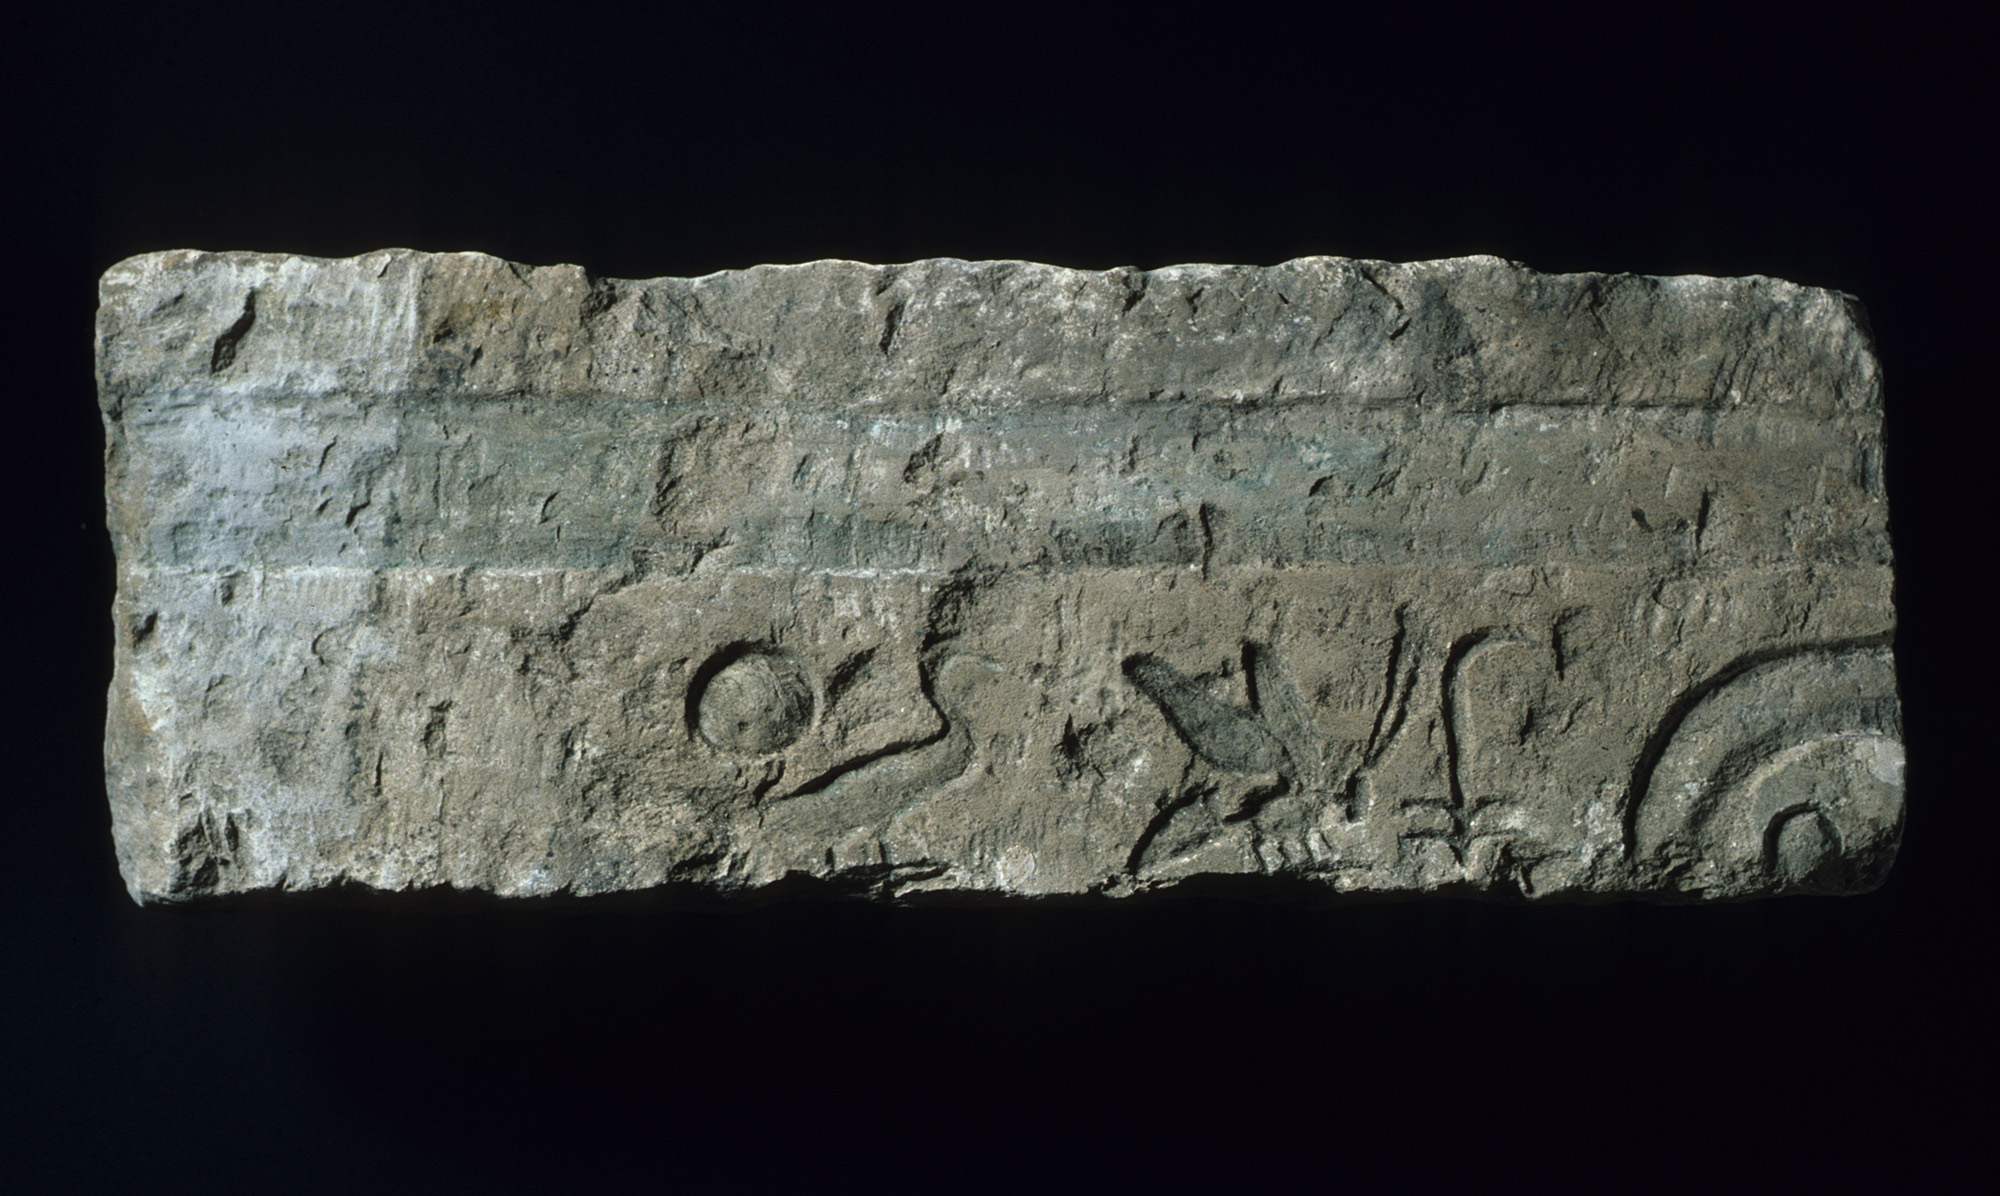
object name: talatat, royal name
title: Relief fragment with royal titles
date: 1353-1336 BCE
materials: limestone, paint